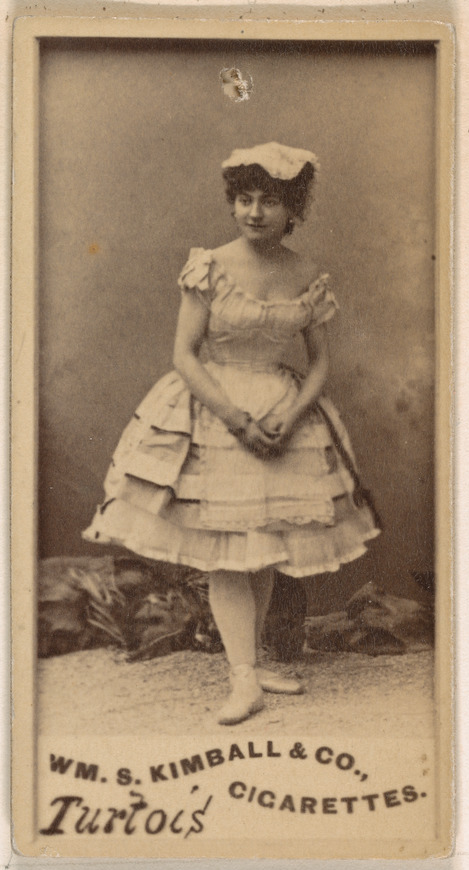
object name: photograph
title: Miss Turtois, from the Actresses series (N203) issued by Wm. S. Kimball & Co.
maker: william s. kimball & company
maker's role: publisher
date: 1889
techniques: color lithograph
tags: portraits,women,actresses